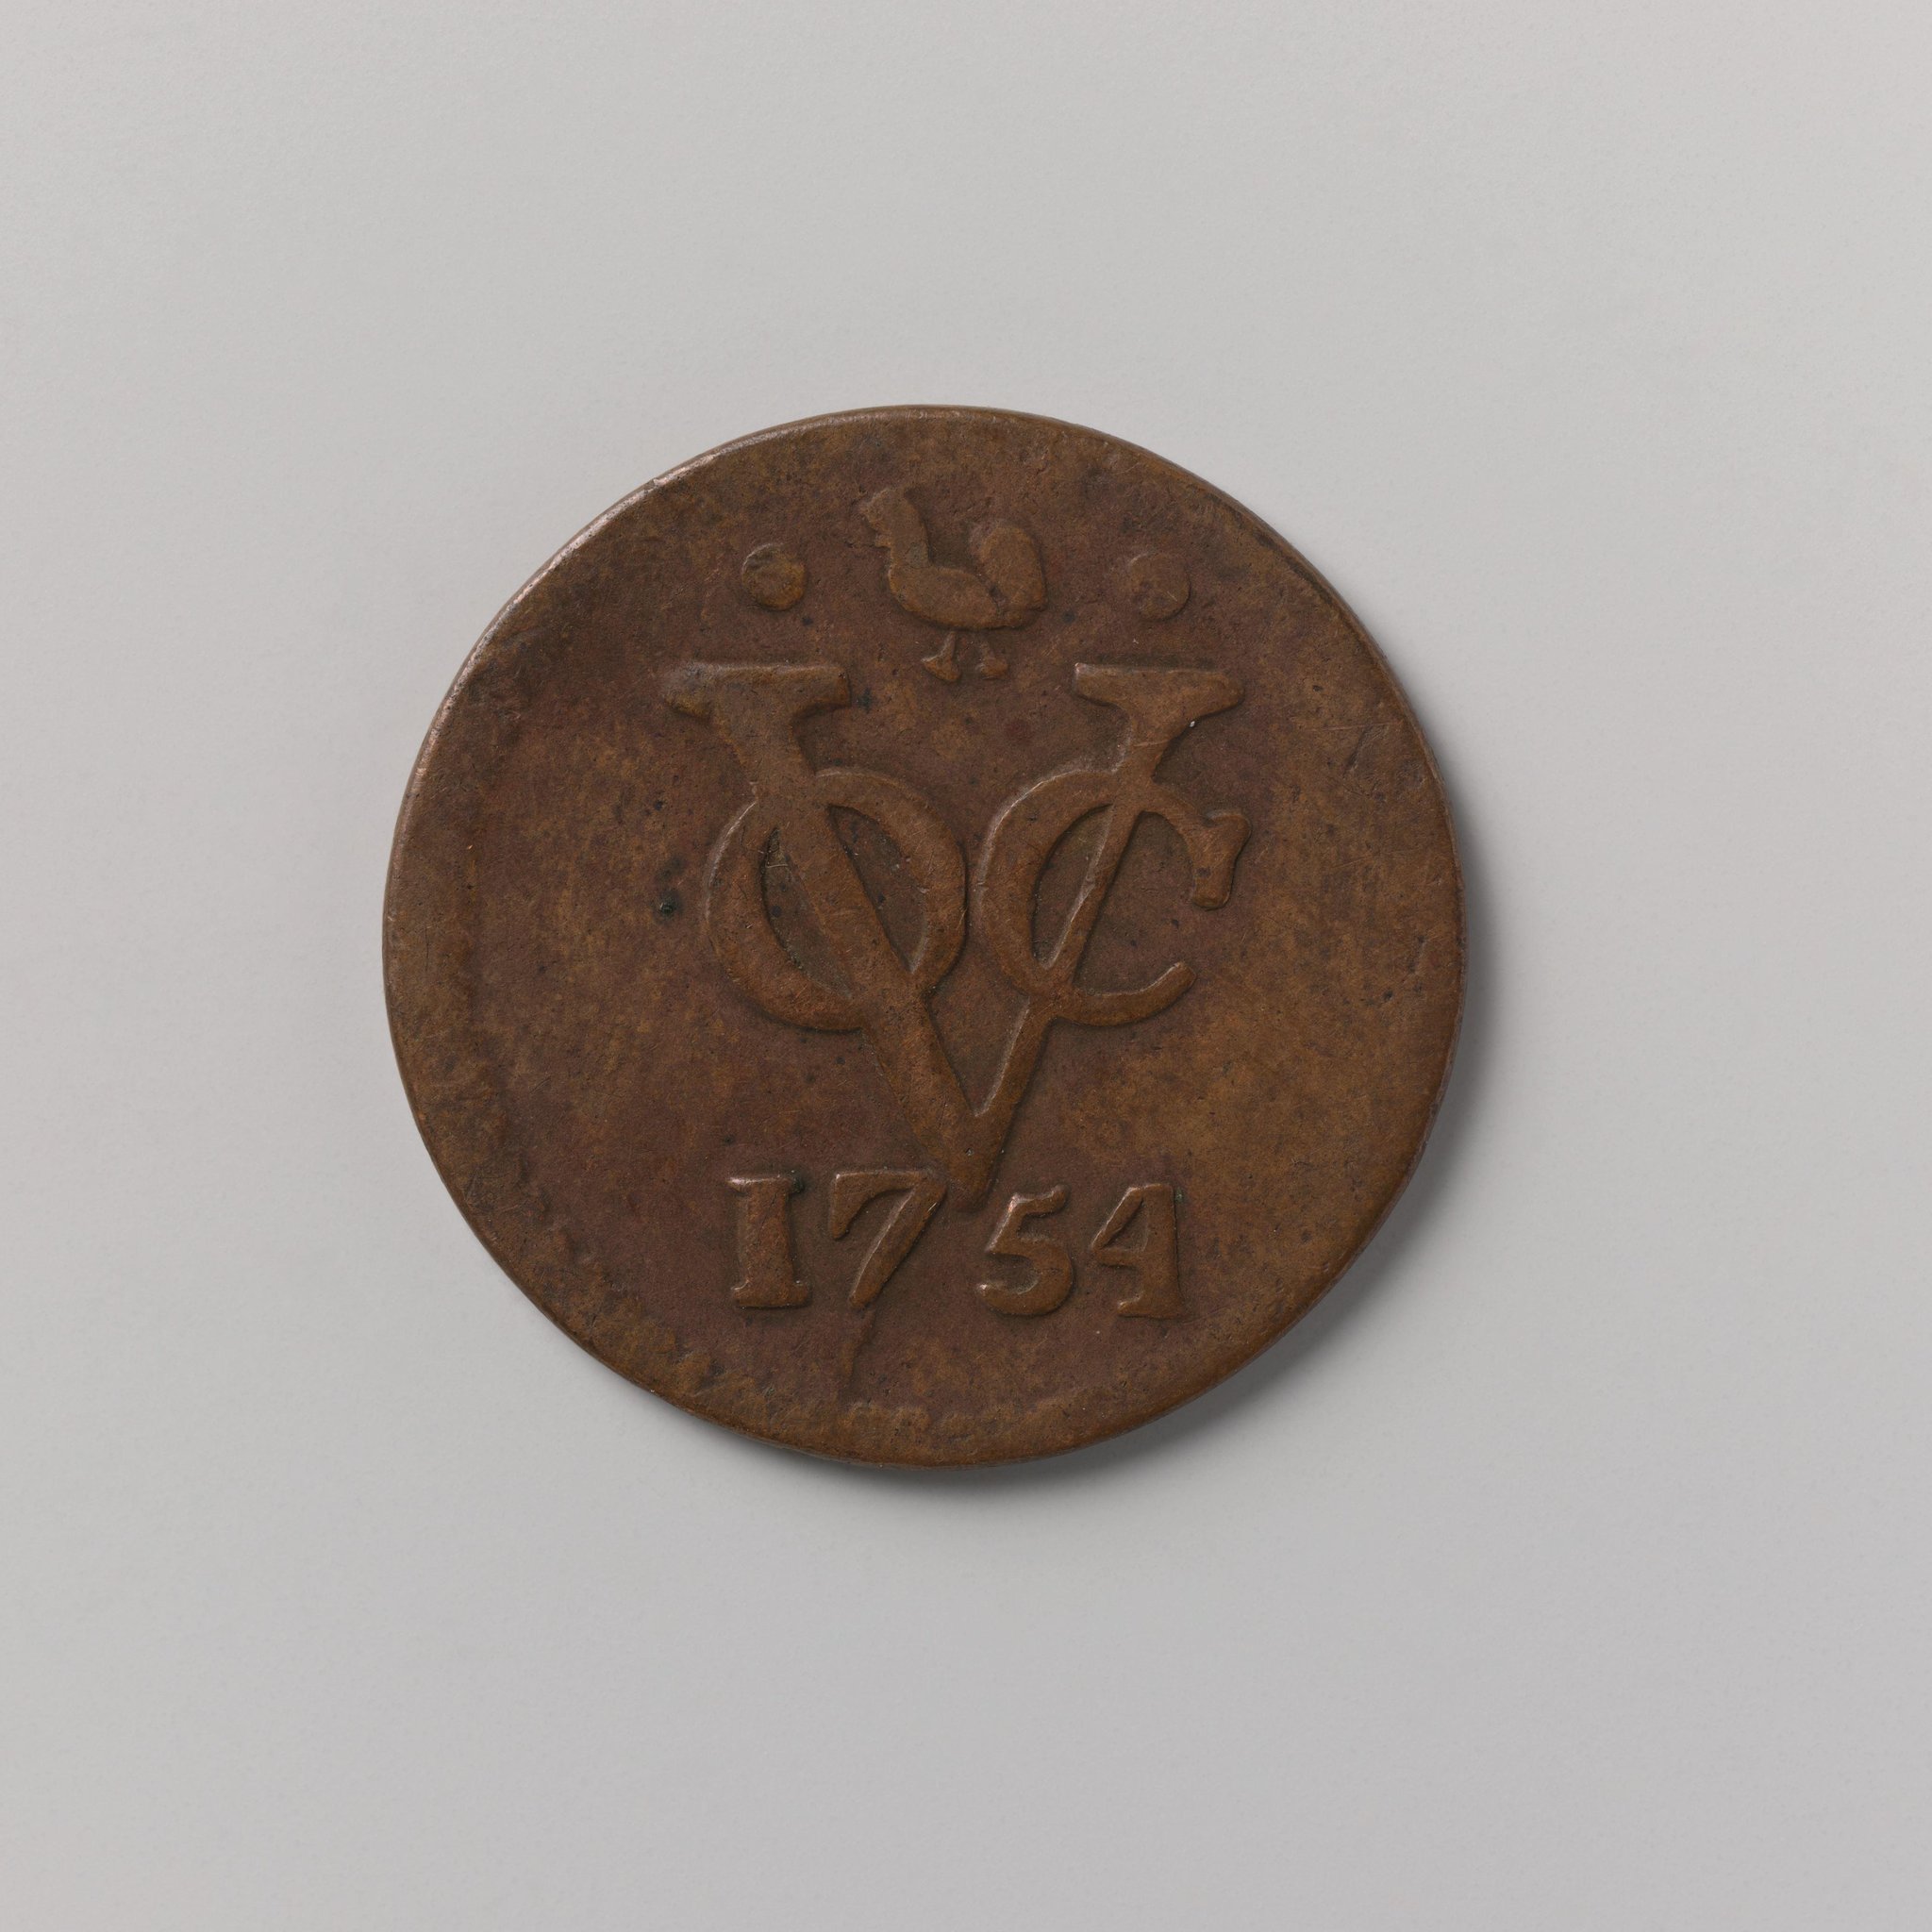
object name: coin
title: VOC, duit Westfriesland, 1754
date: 1754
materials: copper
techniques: striking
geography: hoorn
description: Koperen munt. Voorzijde: gekroond wapenschild van Westfriesland. Keerzijde: monogram van de VOC, waarboven muntmeesterteken en waaronder jaartal. Gladde rand.